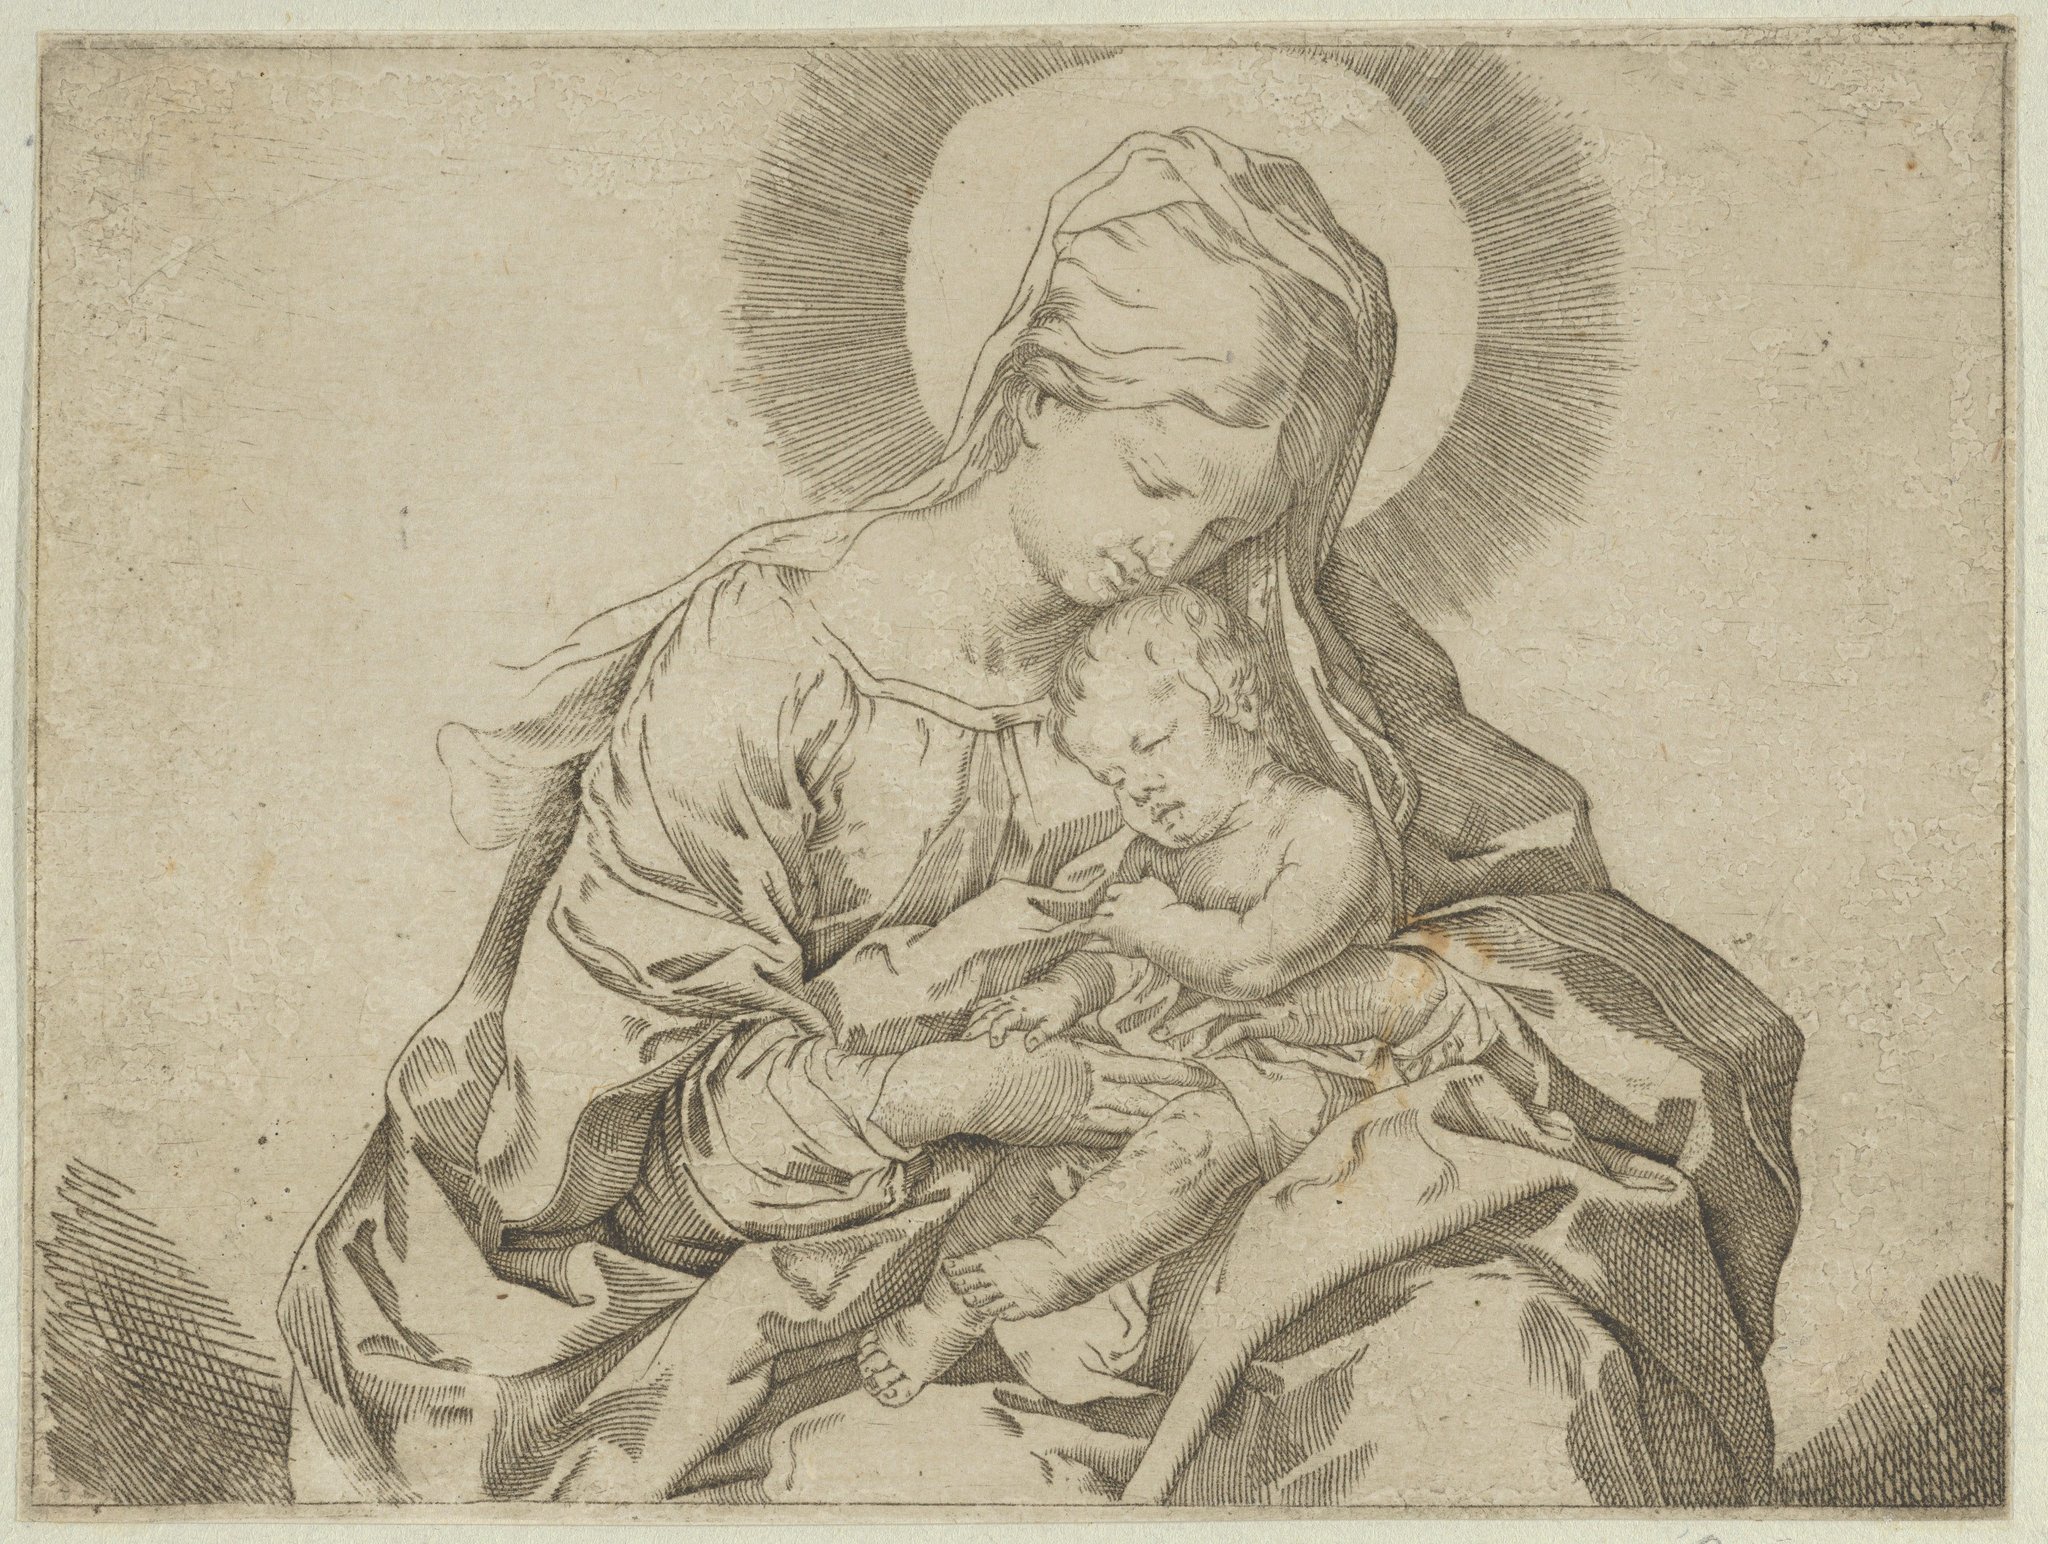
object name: print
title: The Virgin holding the infant Christ, after Reni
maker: anonymous, 17th century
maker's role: artist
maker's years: 1600-1700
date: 1600-1640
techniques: etching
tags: christ,madonna and child,virgin mary